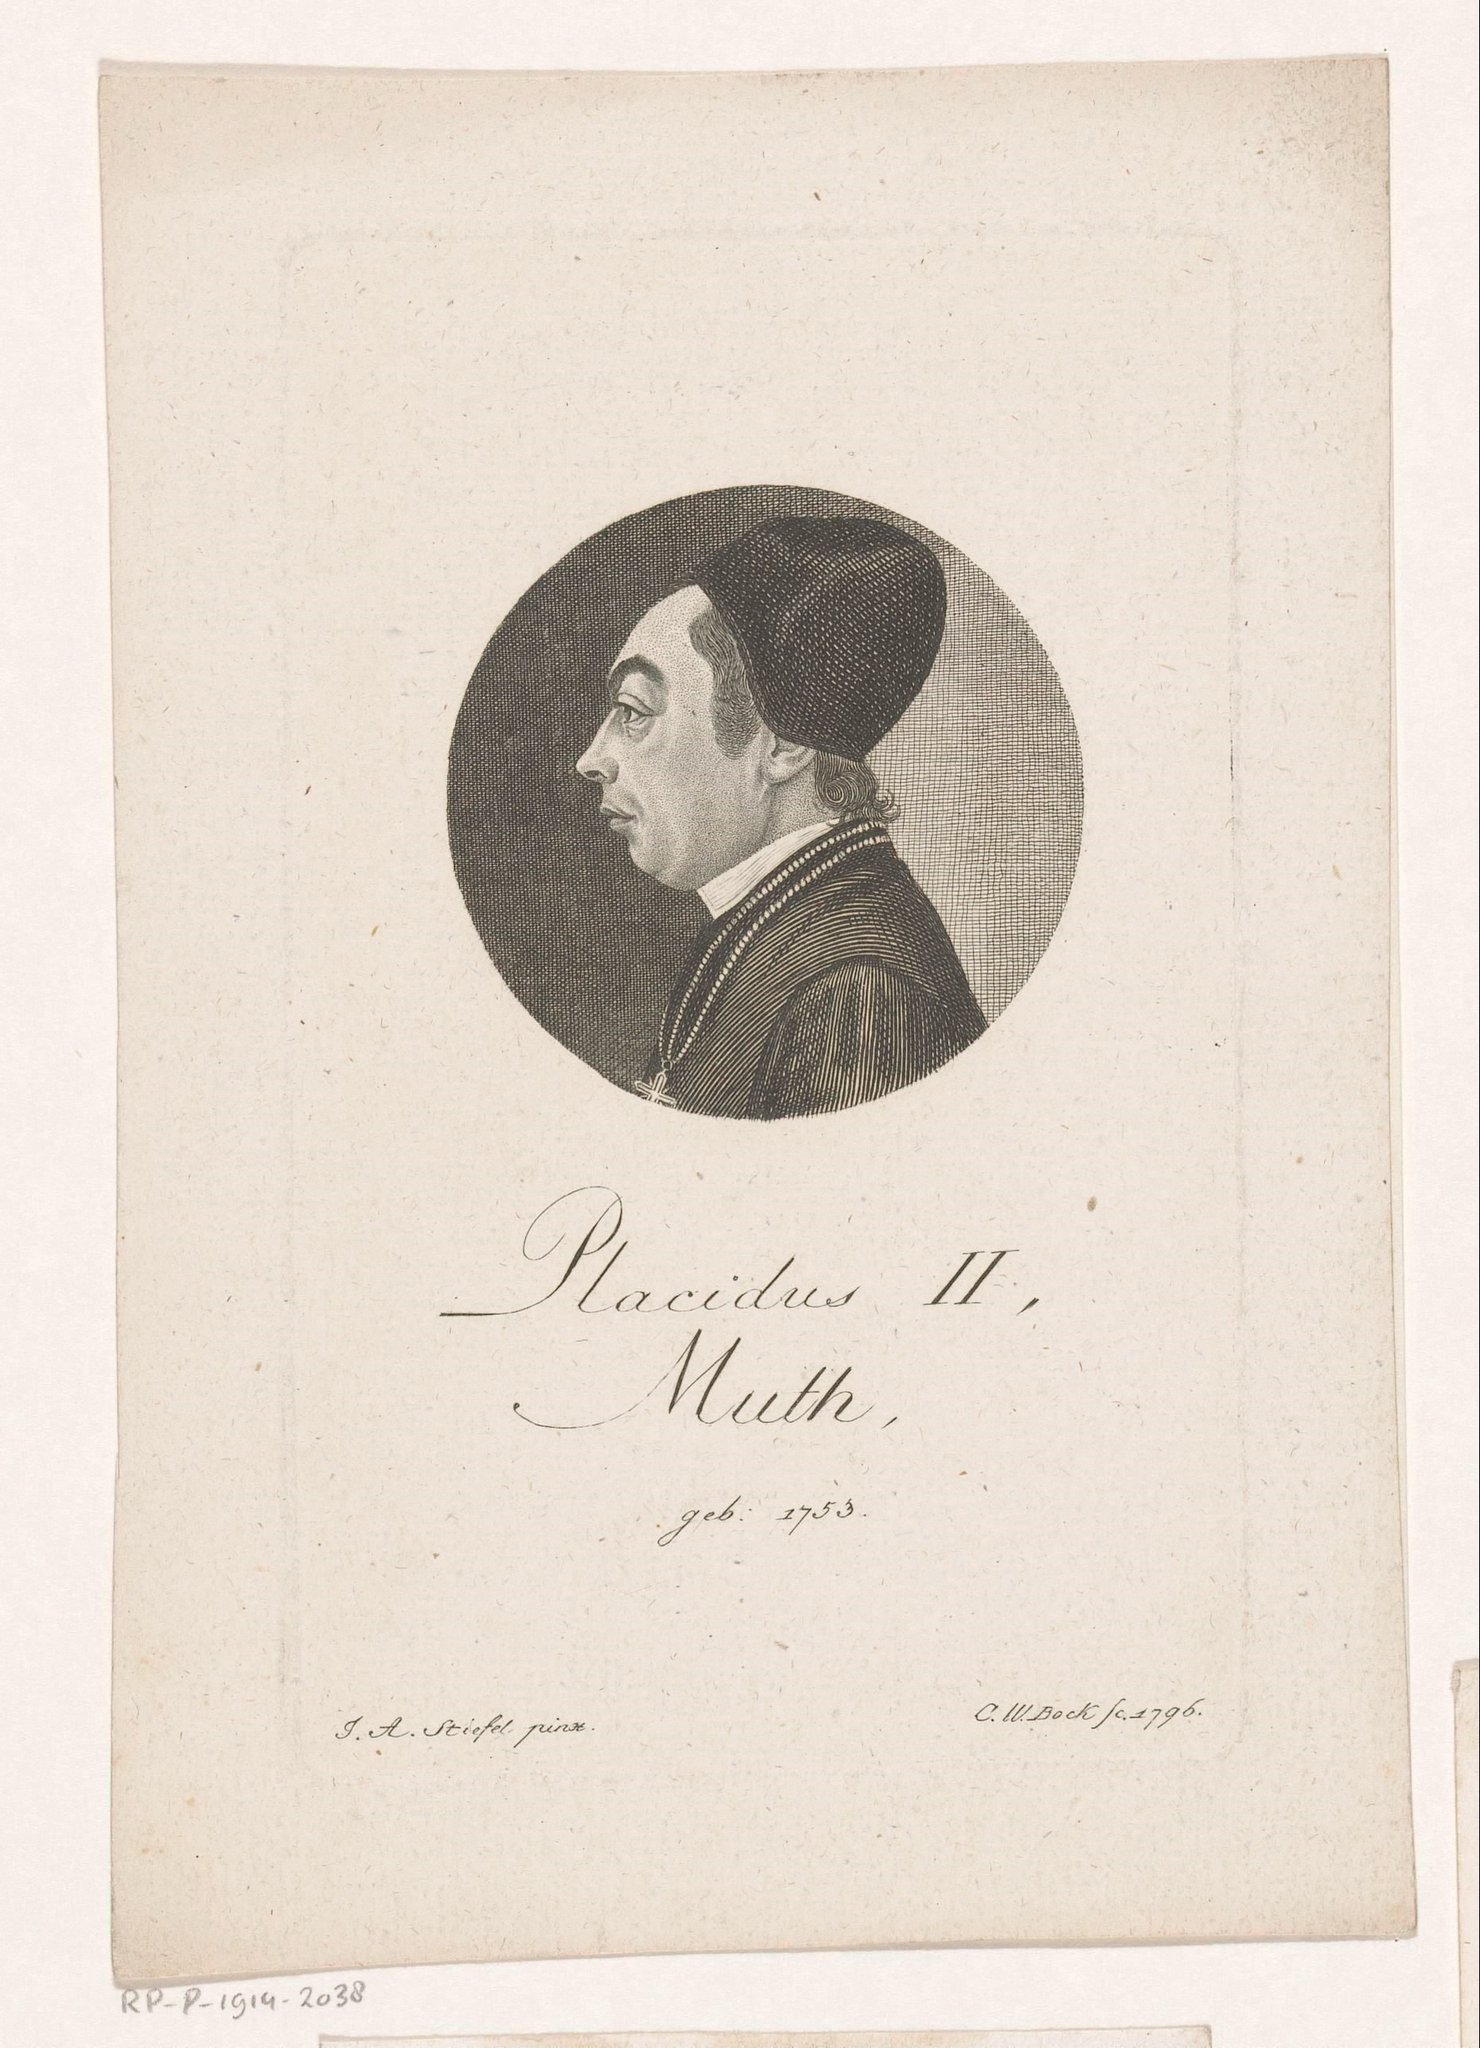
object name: print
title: Portret van Placidus Muth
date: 1796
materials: paper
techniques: engraving, etching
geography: nuremberg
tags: historical persons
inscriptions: collector's mark: Lugt 2228